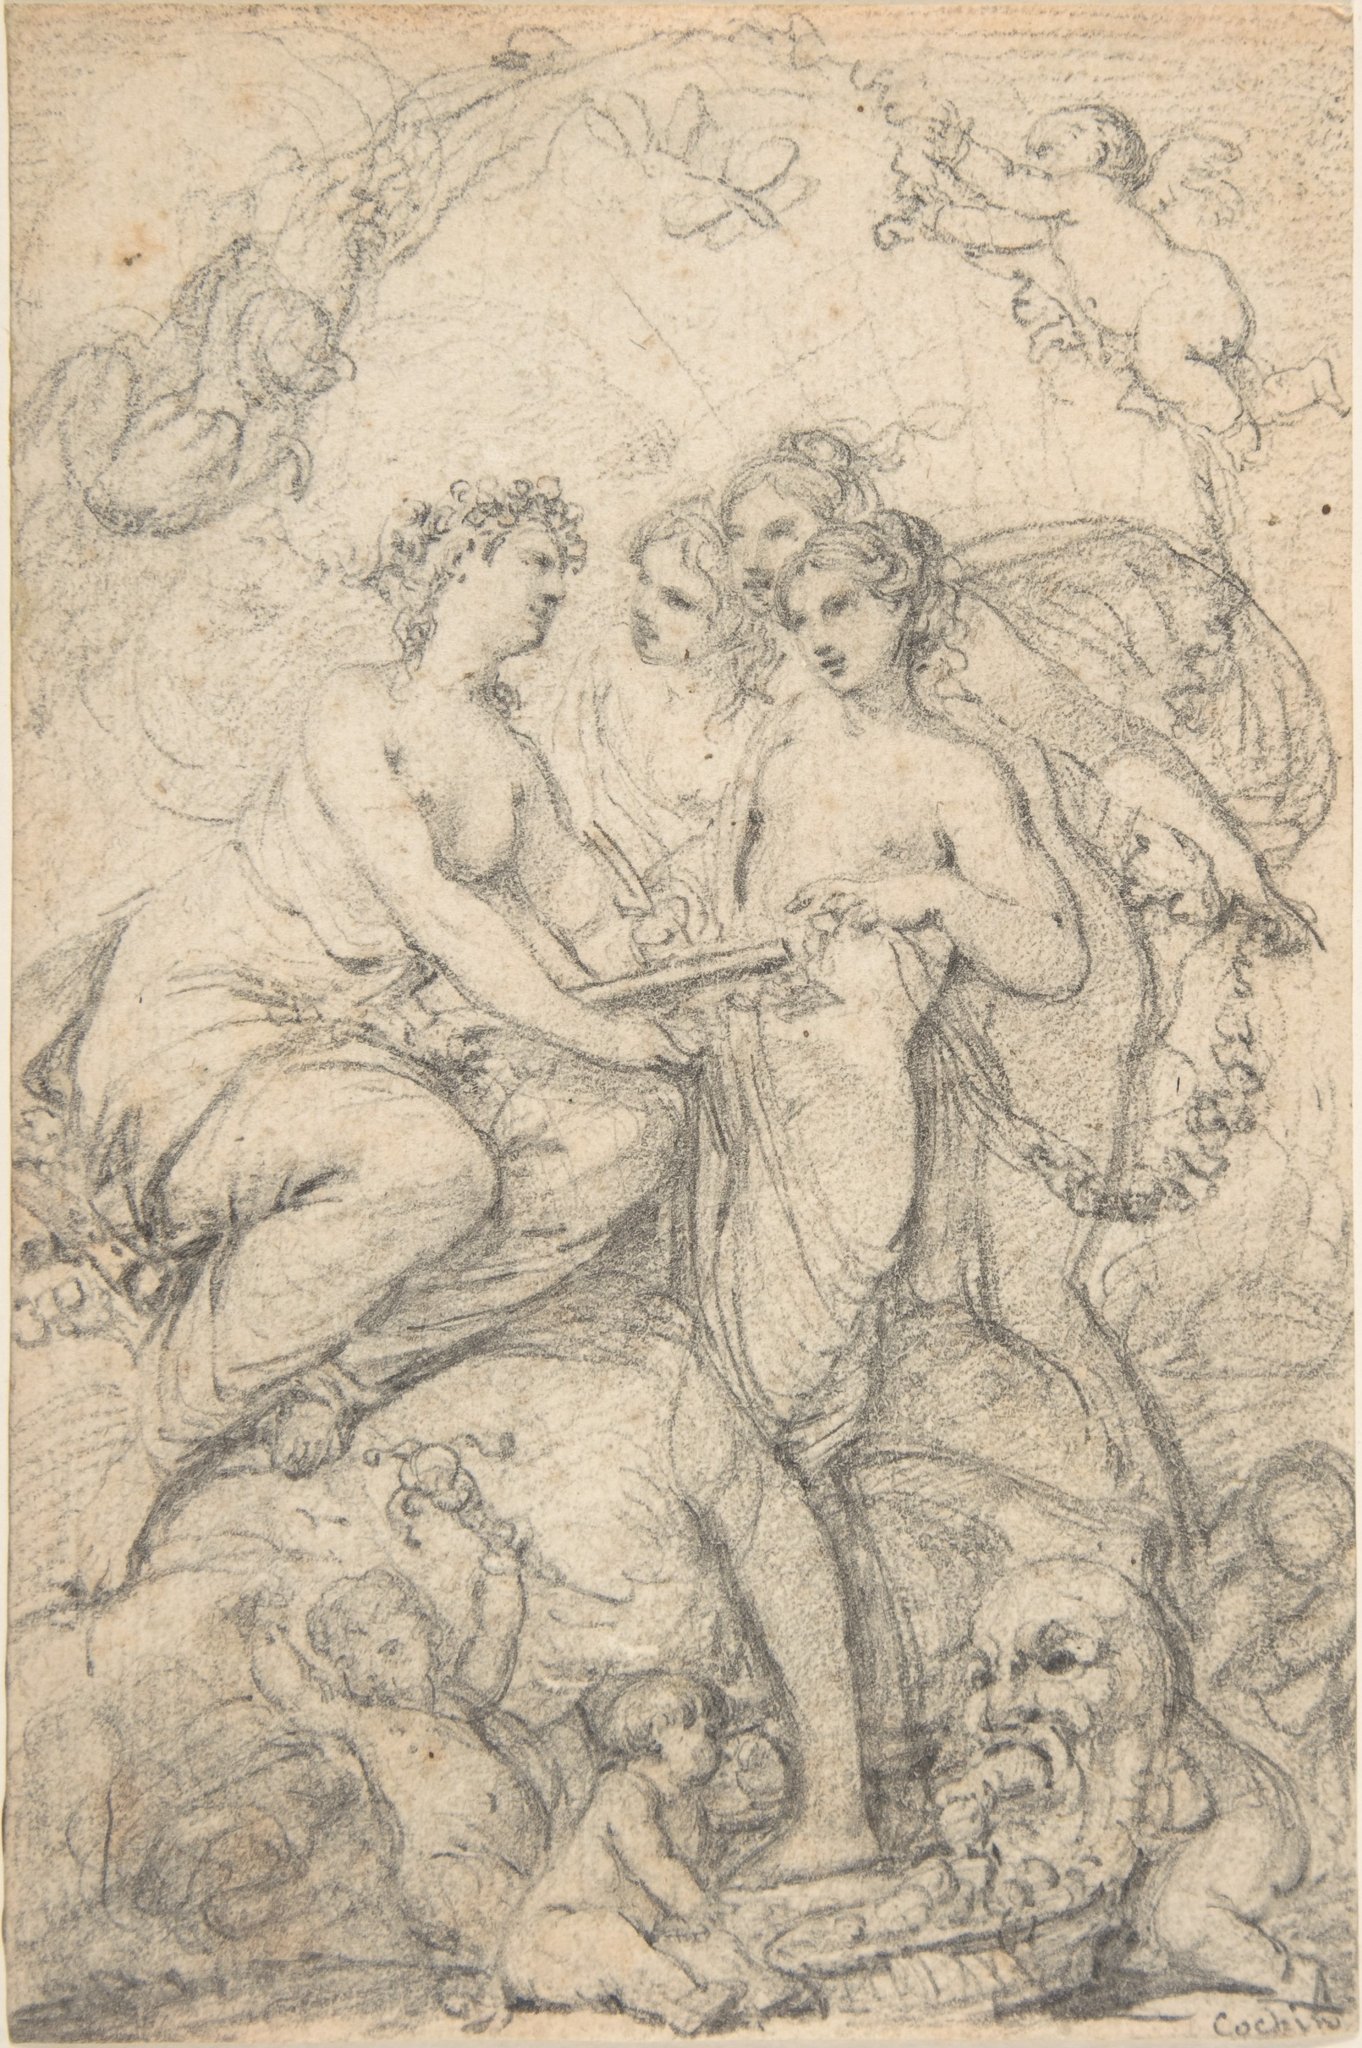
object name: drawing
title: Design for a Book Illustration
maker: charles nicolas cochin ii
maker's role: artist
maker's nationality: french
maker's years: 1715-1790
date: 1701-1800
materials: chalk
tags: infants,women